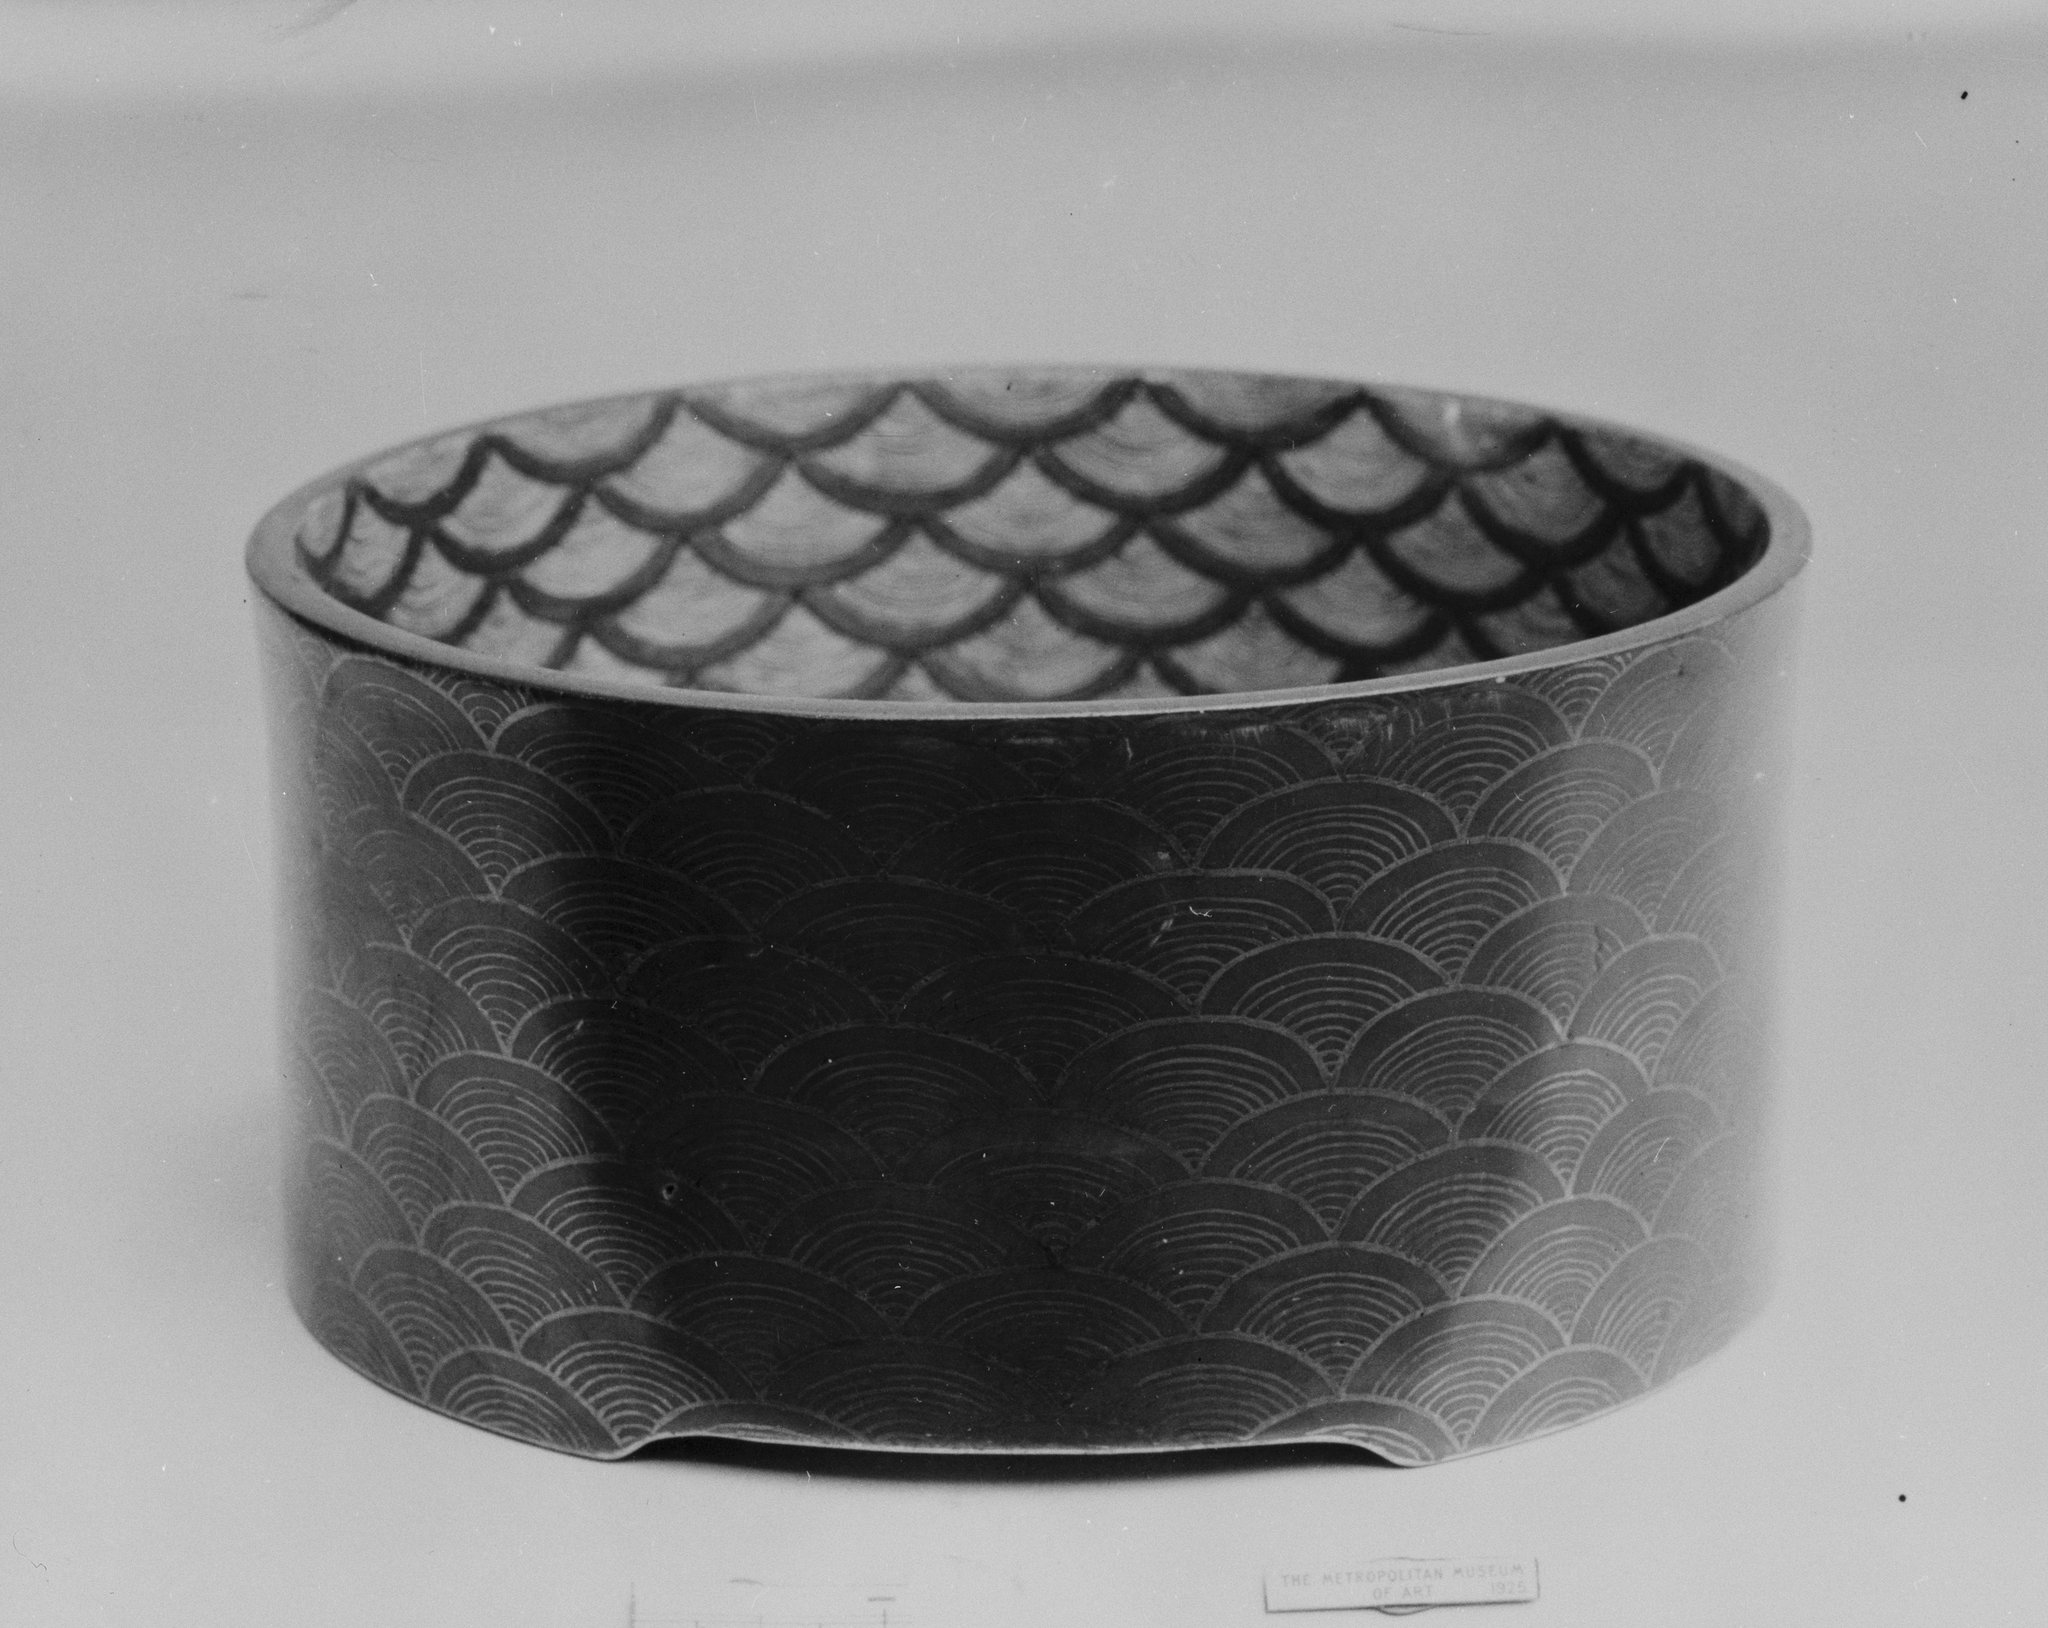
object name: bowl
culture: japanese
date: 1801-1900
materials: gold, porcelain